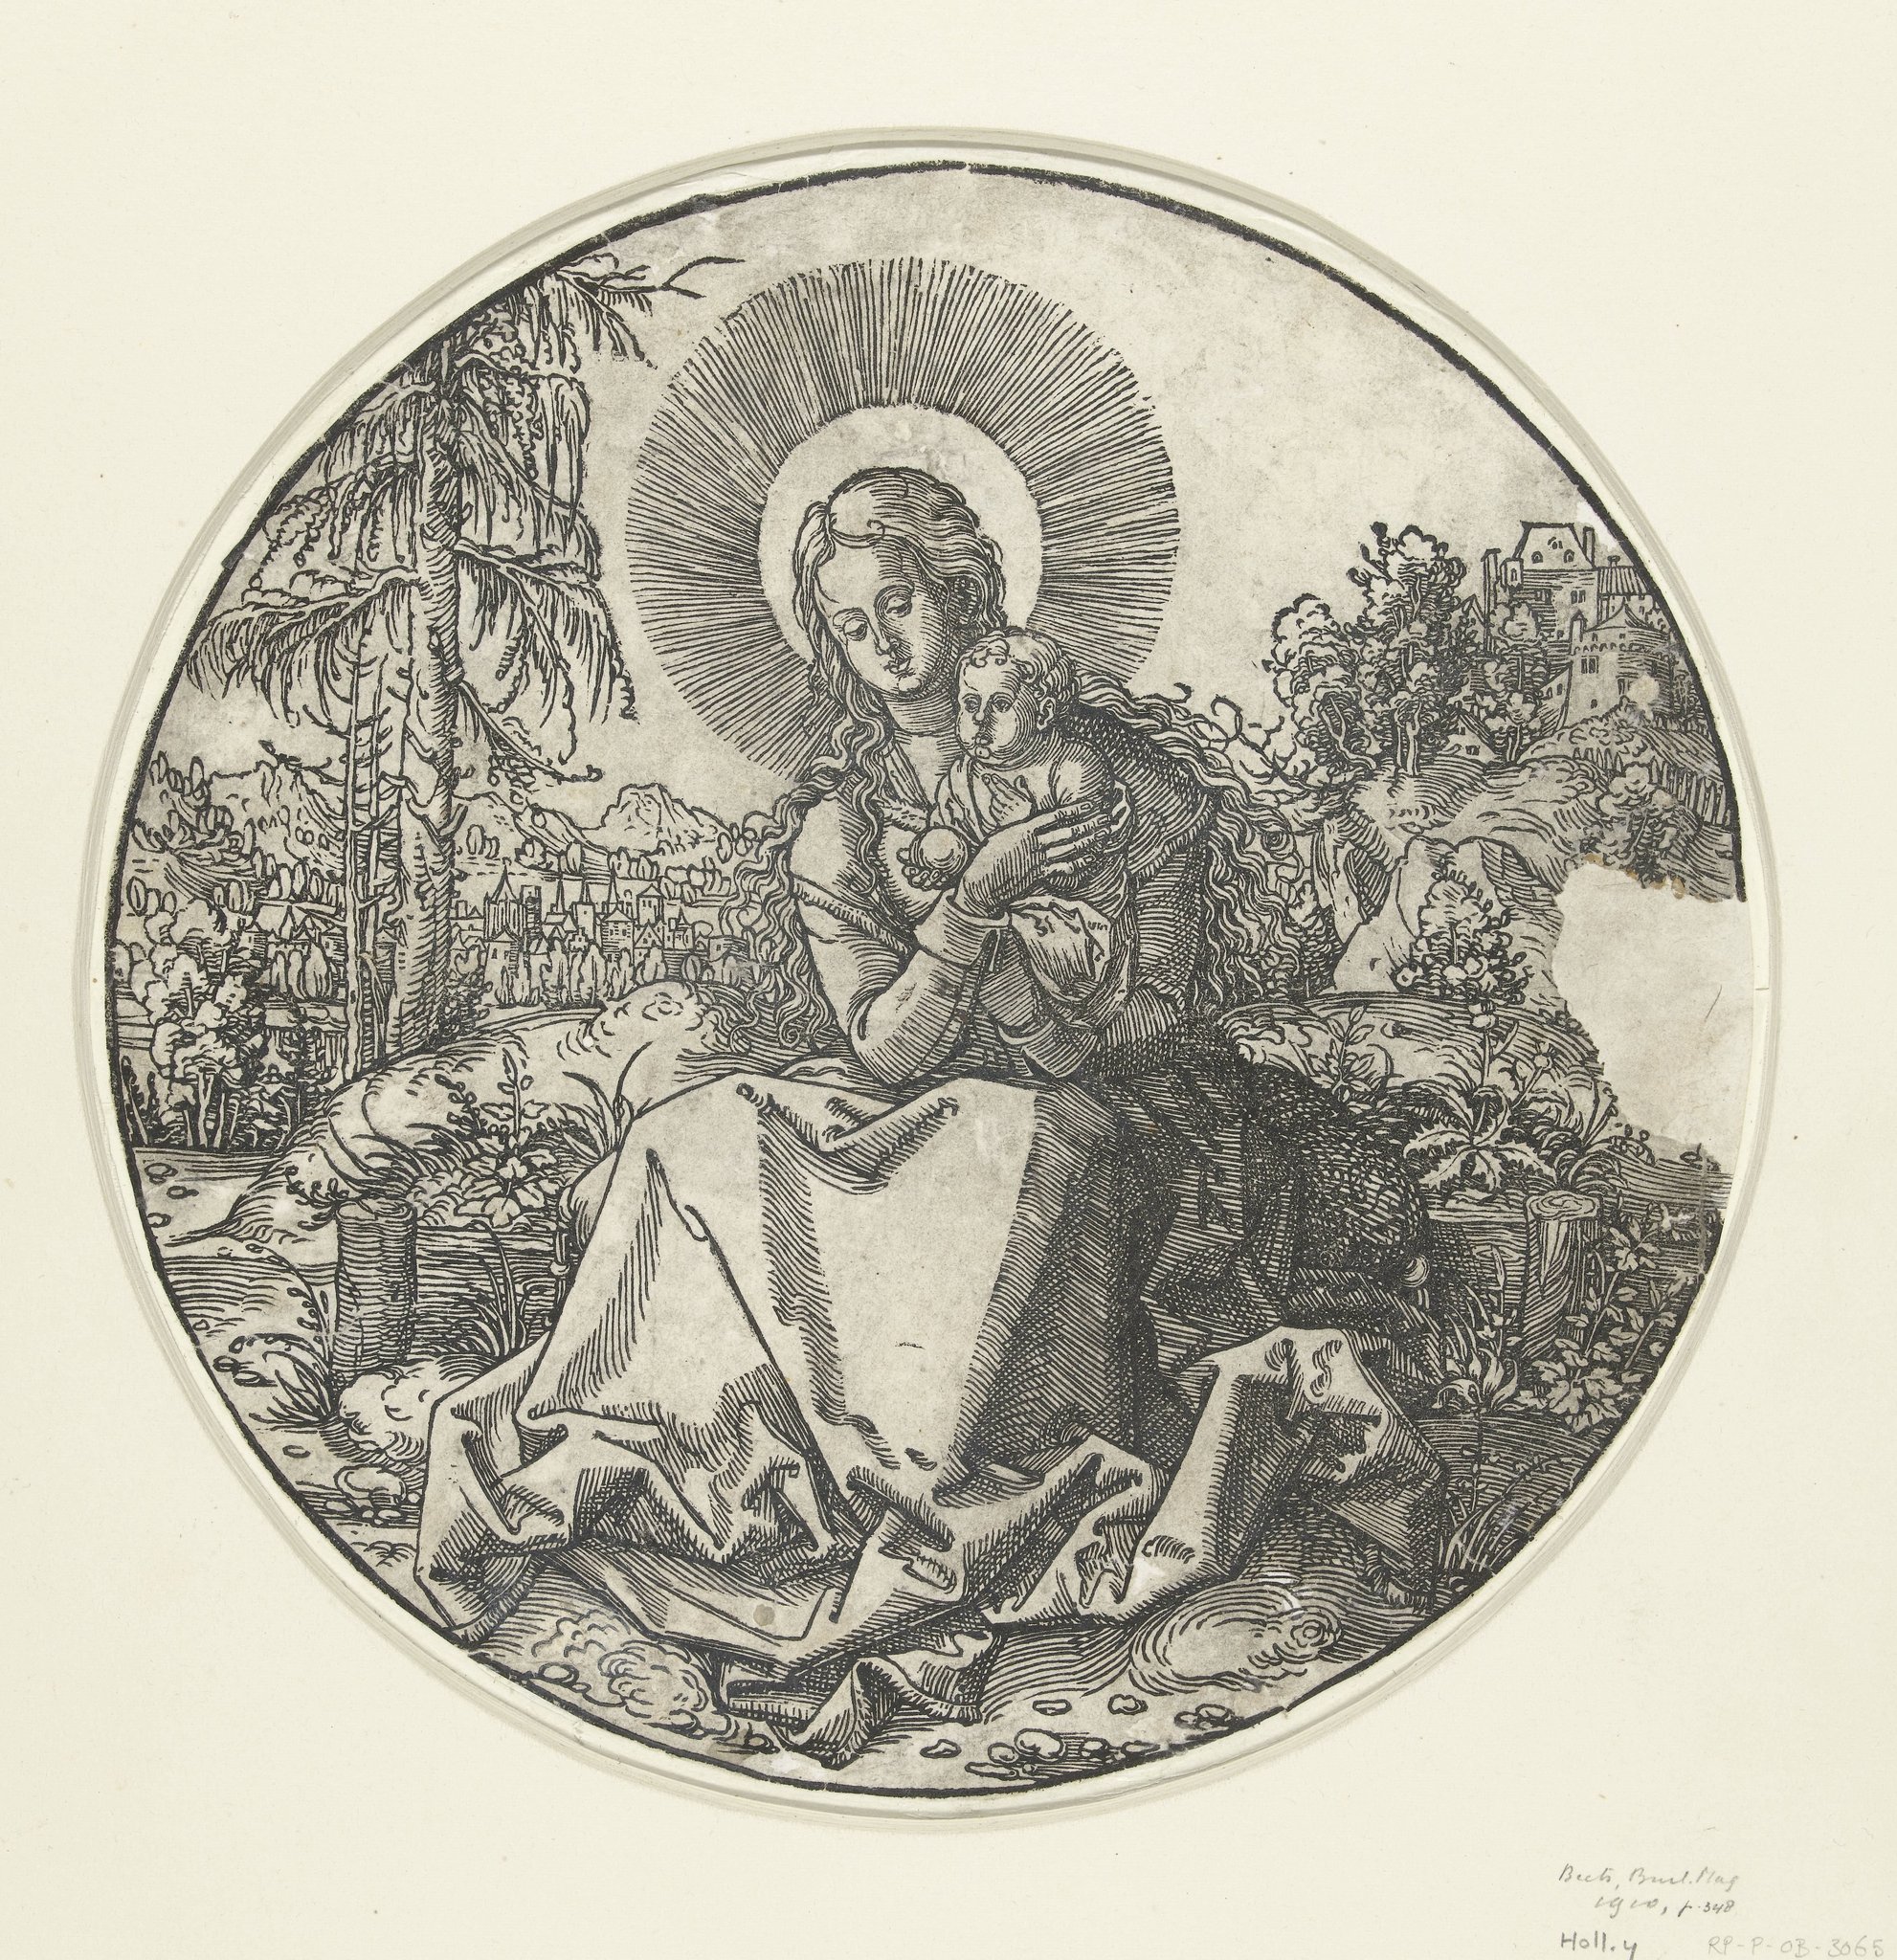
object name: print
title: Zittende Madonna met kind in een landschap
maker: Anonymous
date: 1500-1600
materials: paper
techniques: woodcut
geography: southern germany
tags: madonna: mary sitting on the ground, the christ-child in her lap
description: Maria met het Christuskind in haar armen, zittend op de grond in een landschap. Aan weerszijden van haar een boomstronk.